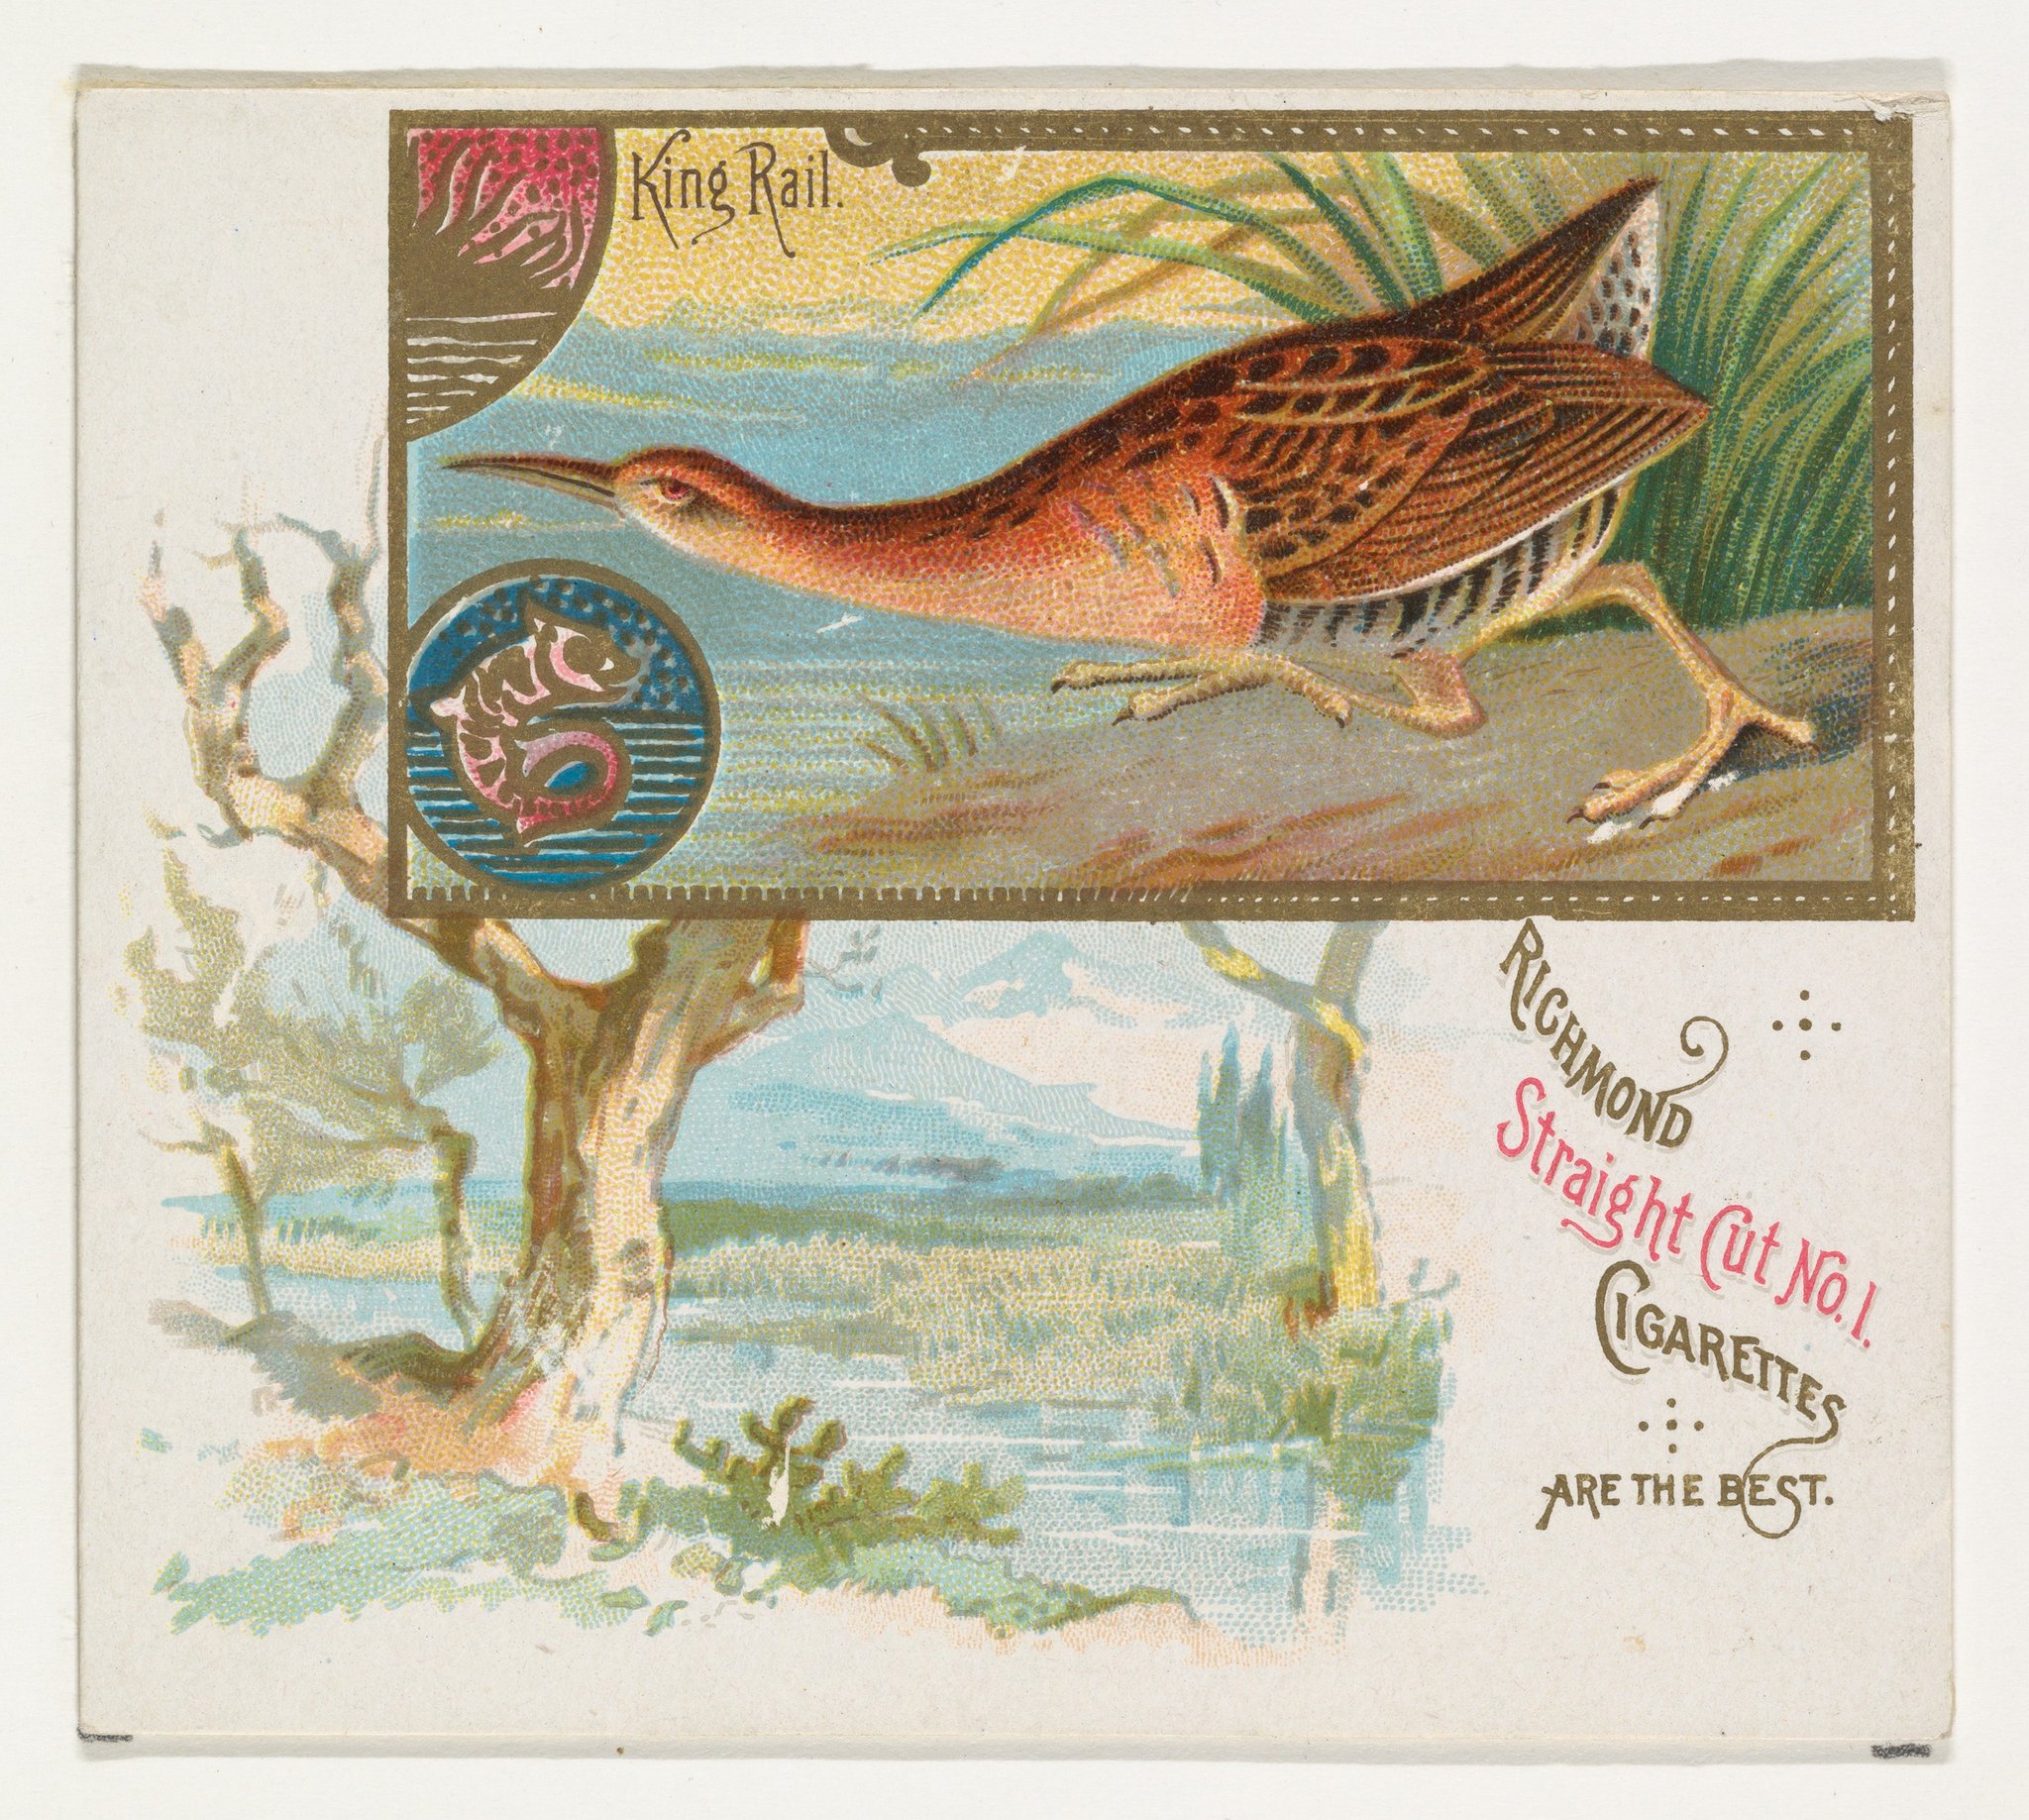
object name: print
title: King Rail, from the Game Birds series (N40) for Allen & Ginter Cigarettes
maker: allen & ginter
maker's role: publisher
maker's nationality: american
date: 1888-1890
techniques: color lithograph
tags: birds